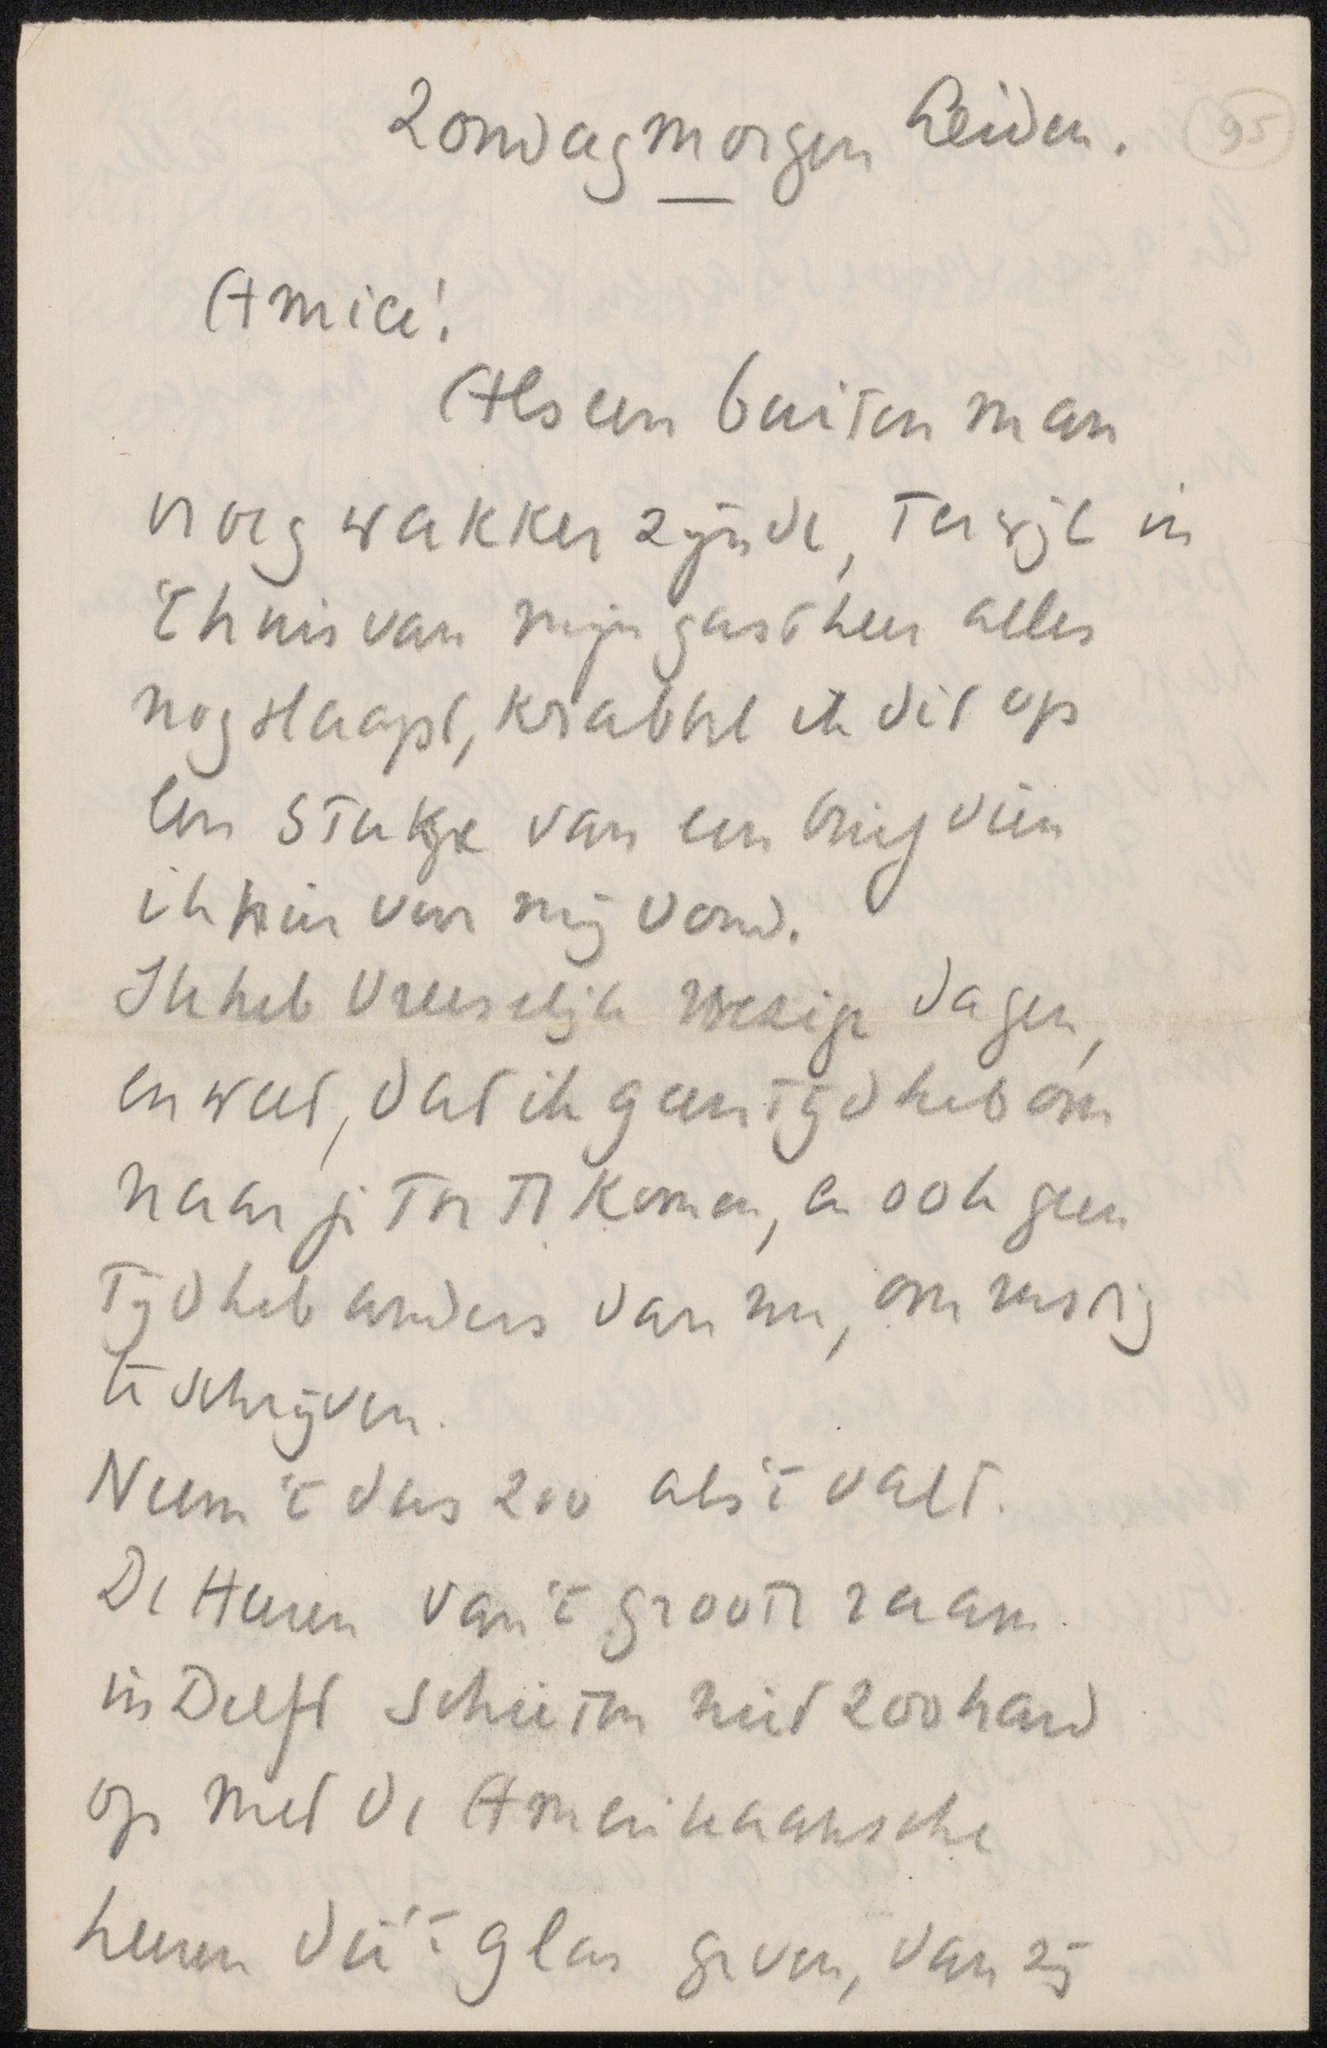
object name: letter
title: Brief aan Willem Bogtman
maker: richard nicolaüs roland holst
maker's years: 1868-1938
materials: paper, pencil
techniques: writing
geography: leiden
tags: amsterdam, print maker, pieter hendrik van moerkerken, haarlem, willem bogtman, drawing, sketch, drawing, applied arts, arts and crafts; industrial design, photography, cinematography, education, tuition of the artist (in general), exhibition ~ art, money